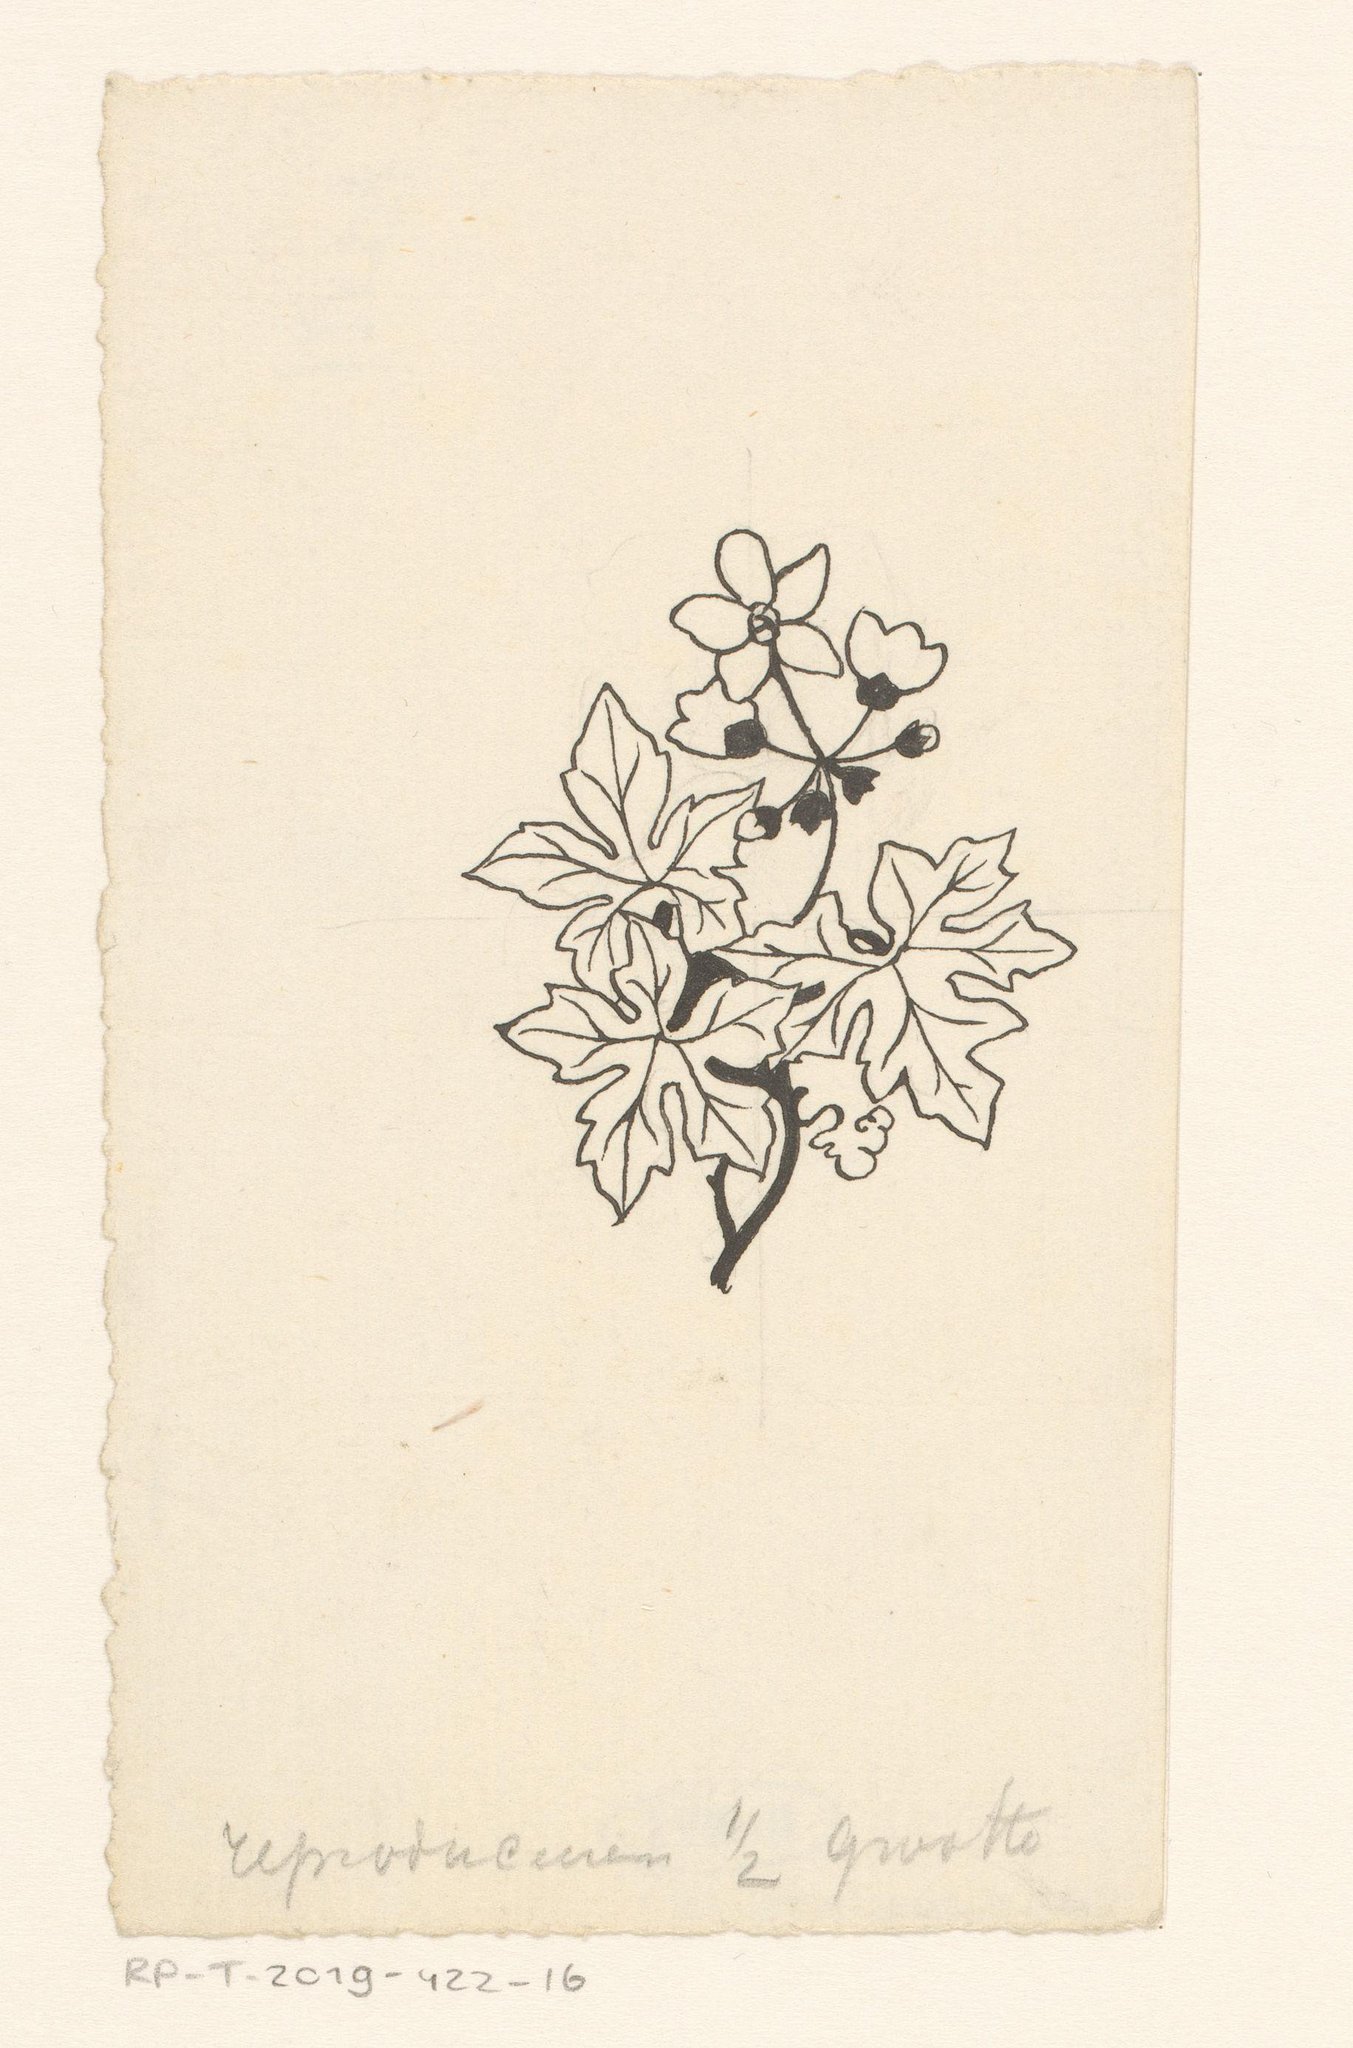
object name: drawing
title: Bladeren en bloemen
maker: willem wenckebach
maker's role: designer, draughtsman, painter, print maker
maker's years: 1860-1937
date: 1870-1937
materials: ink, paper, pencil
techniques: pen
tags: plants (in general) (+ leaf)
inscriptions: collector's mark: Lugt 2228, :